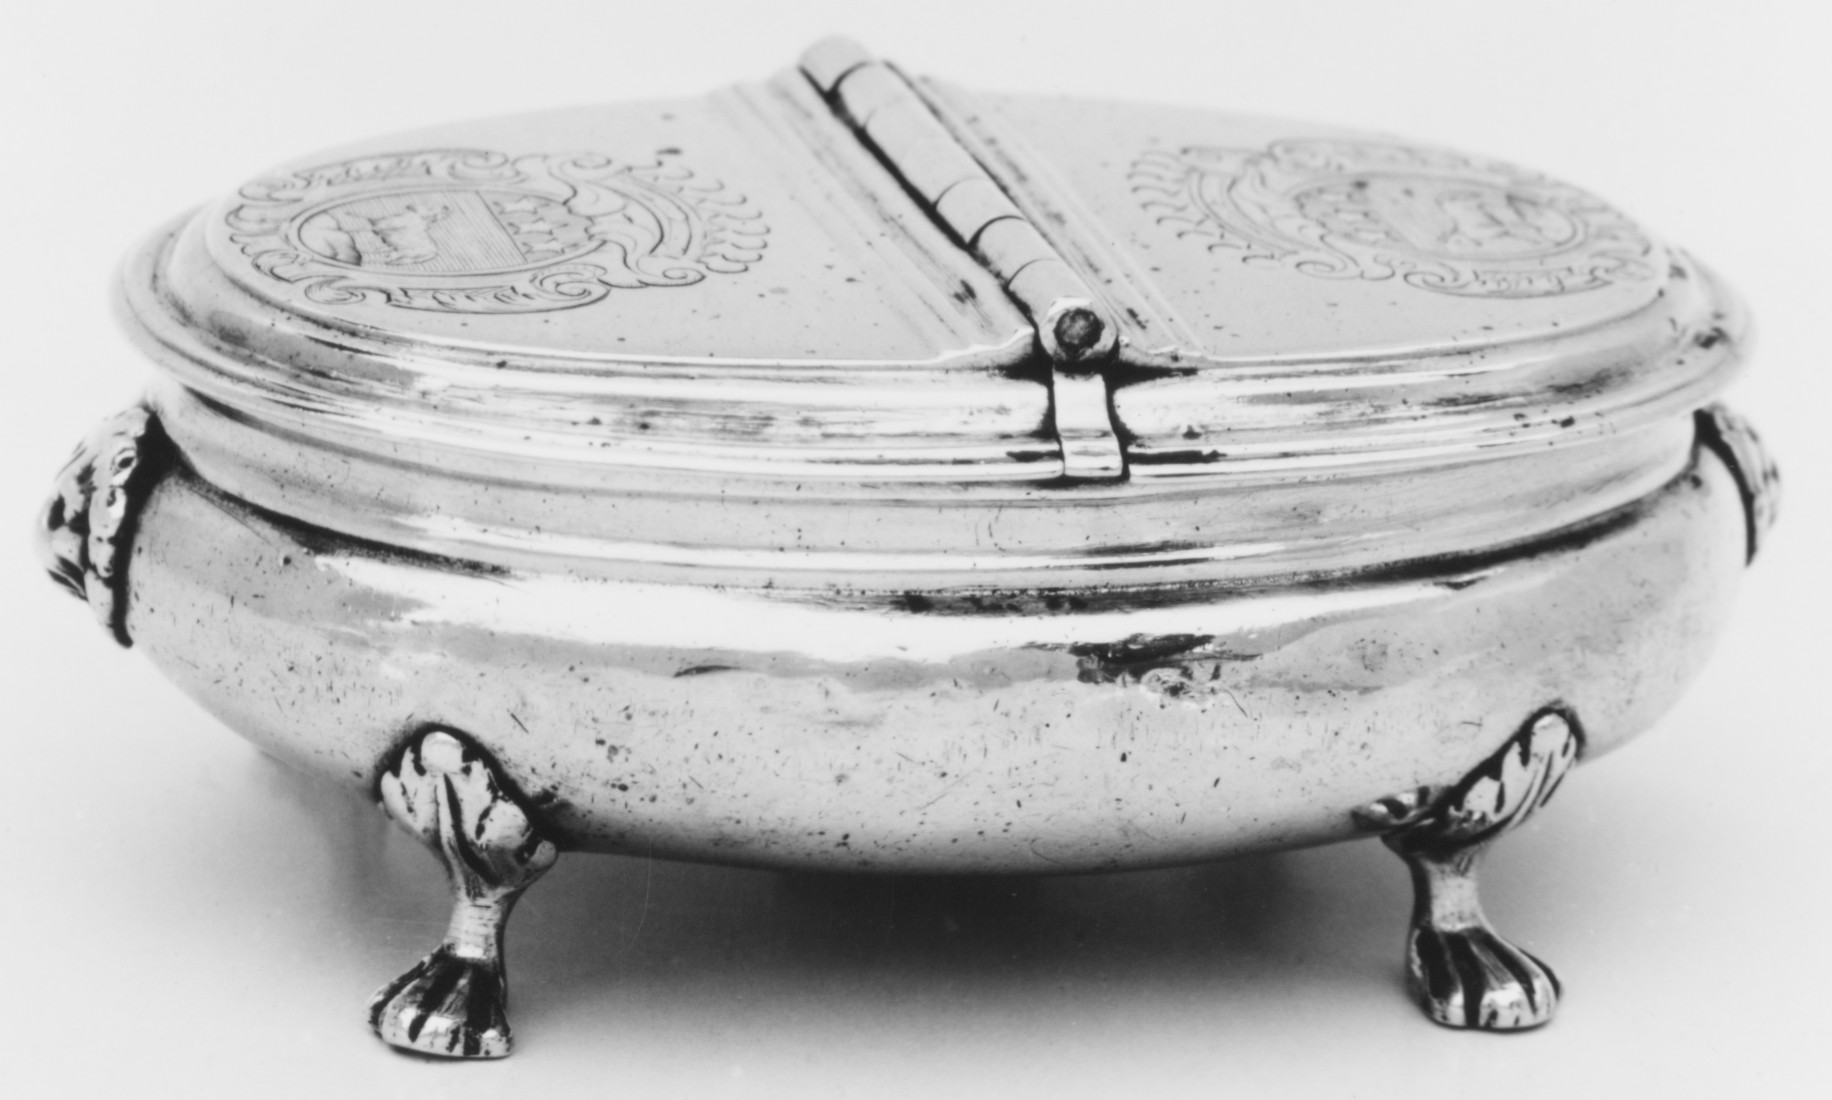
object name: double salt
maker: noël-charles langlois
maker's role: maker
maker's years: 1648-1748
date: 1718-1719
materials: silver